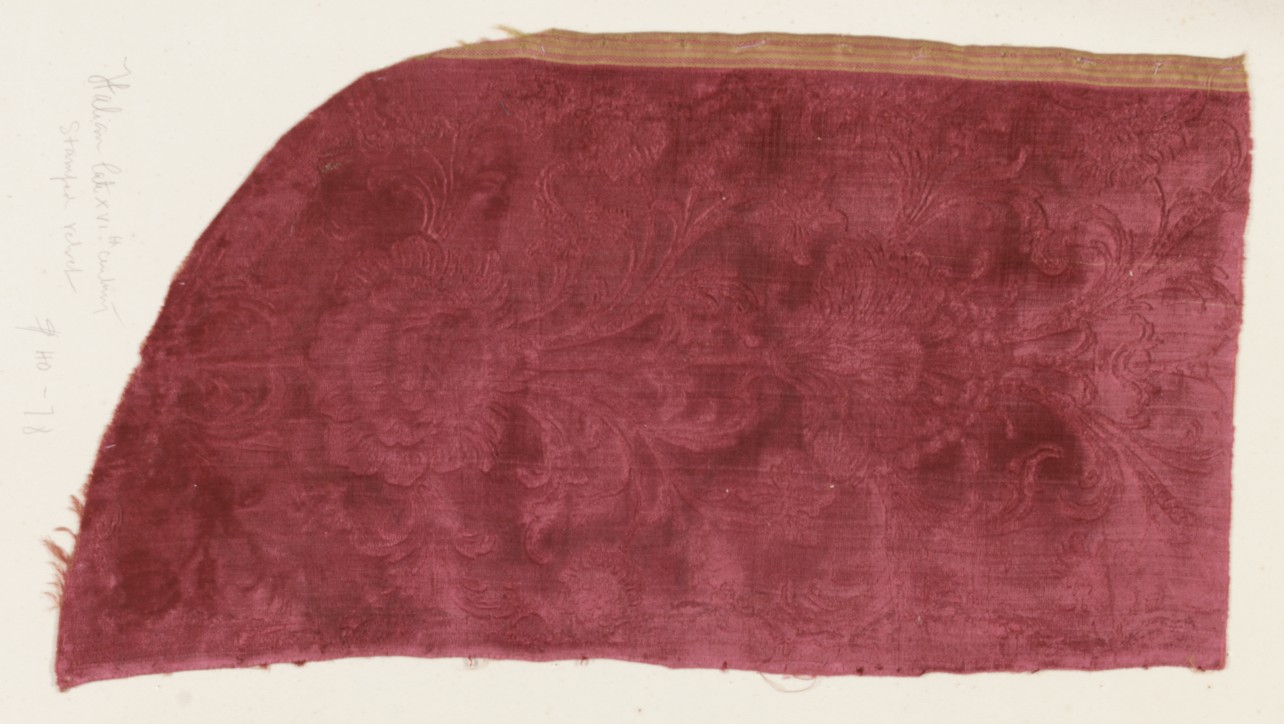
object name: fragment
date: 1567-1600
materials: silk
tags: flowers,leaves